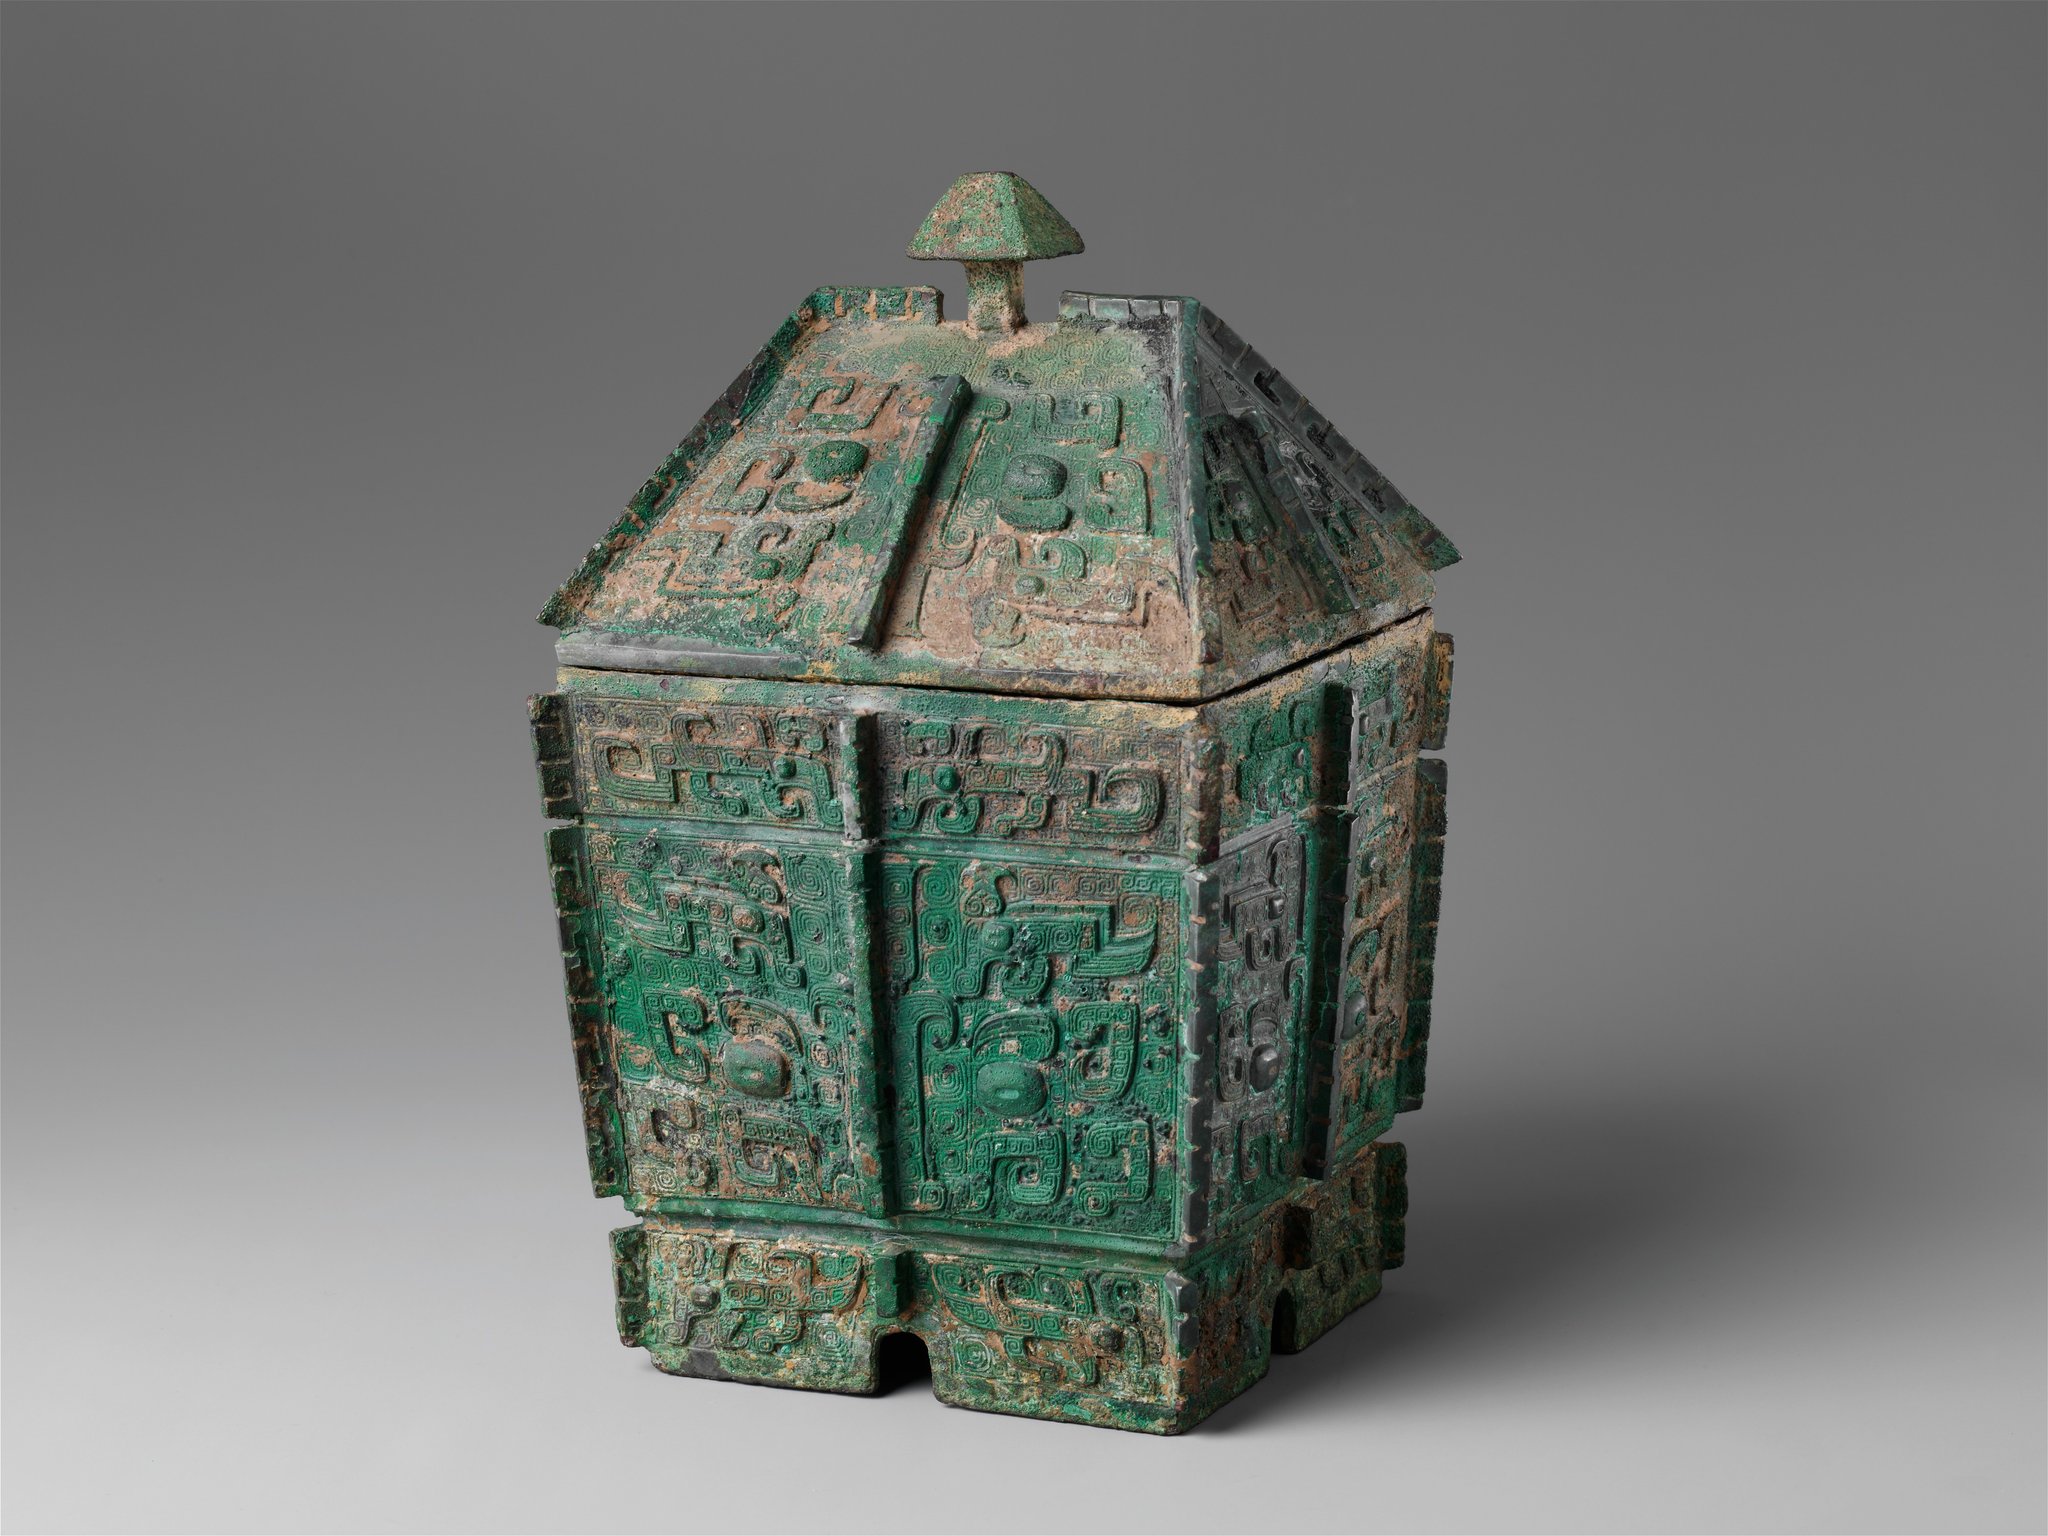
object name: wine container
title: Rectangular wine container (fangyi)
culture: chinese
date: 1300-1001 BCE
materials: bronze